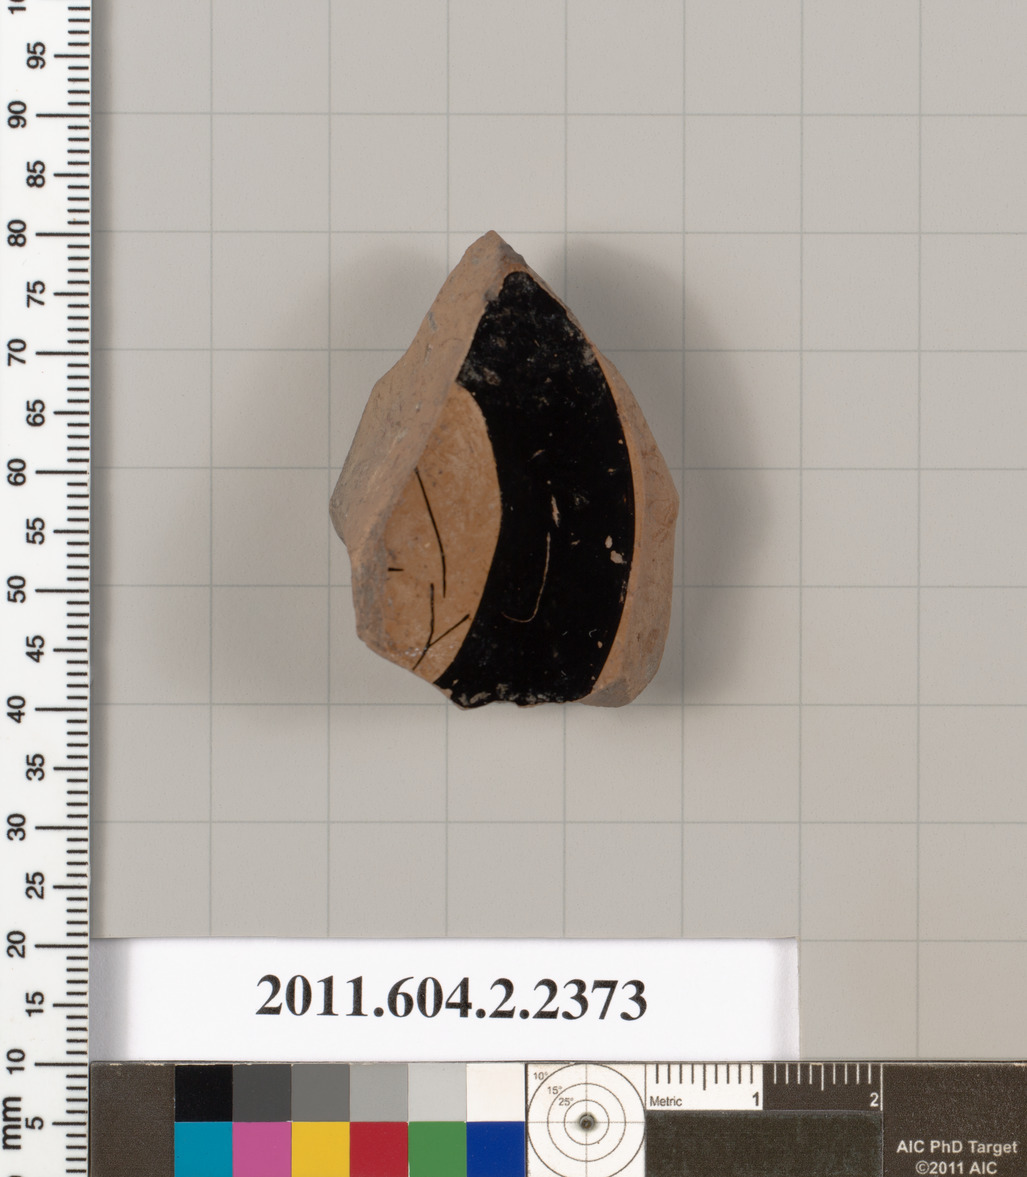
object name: standlet fragment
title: Terracotta fragment of a standlet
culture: greek, attic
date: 500-480 BCE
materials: terracotta